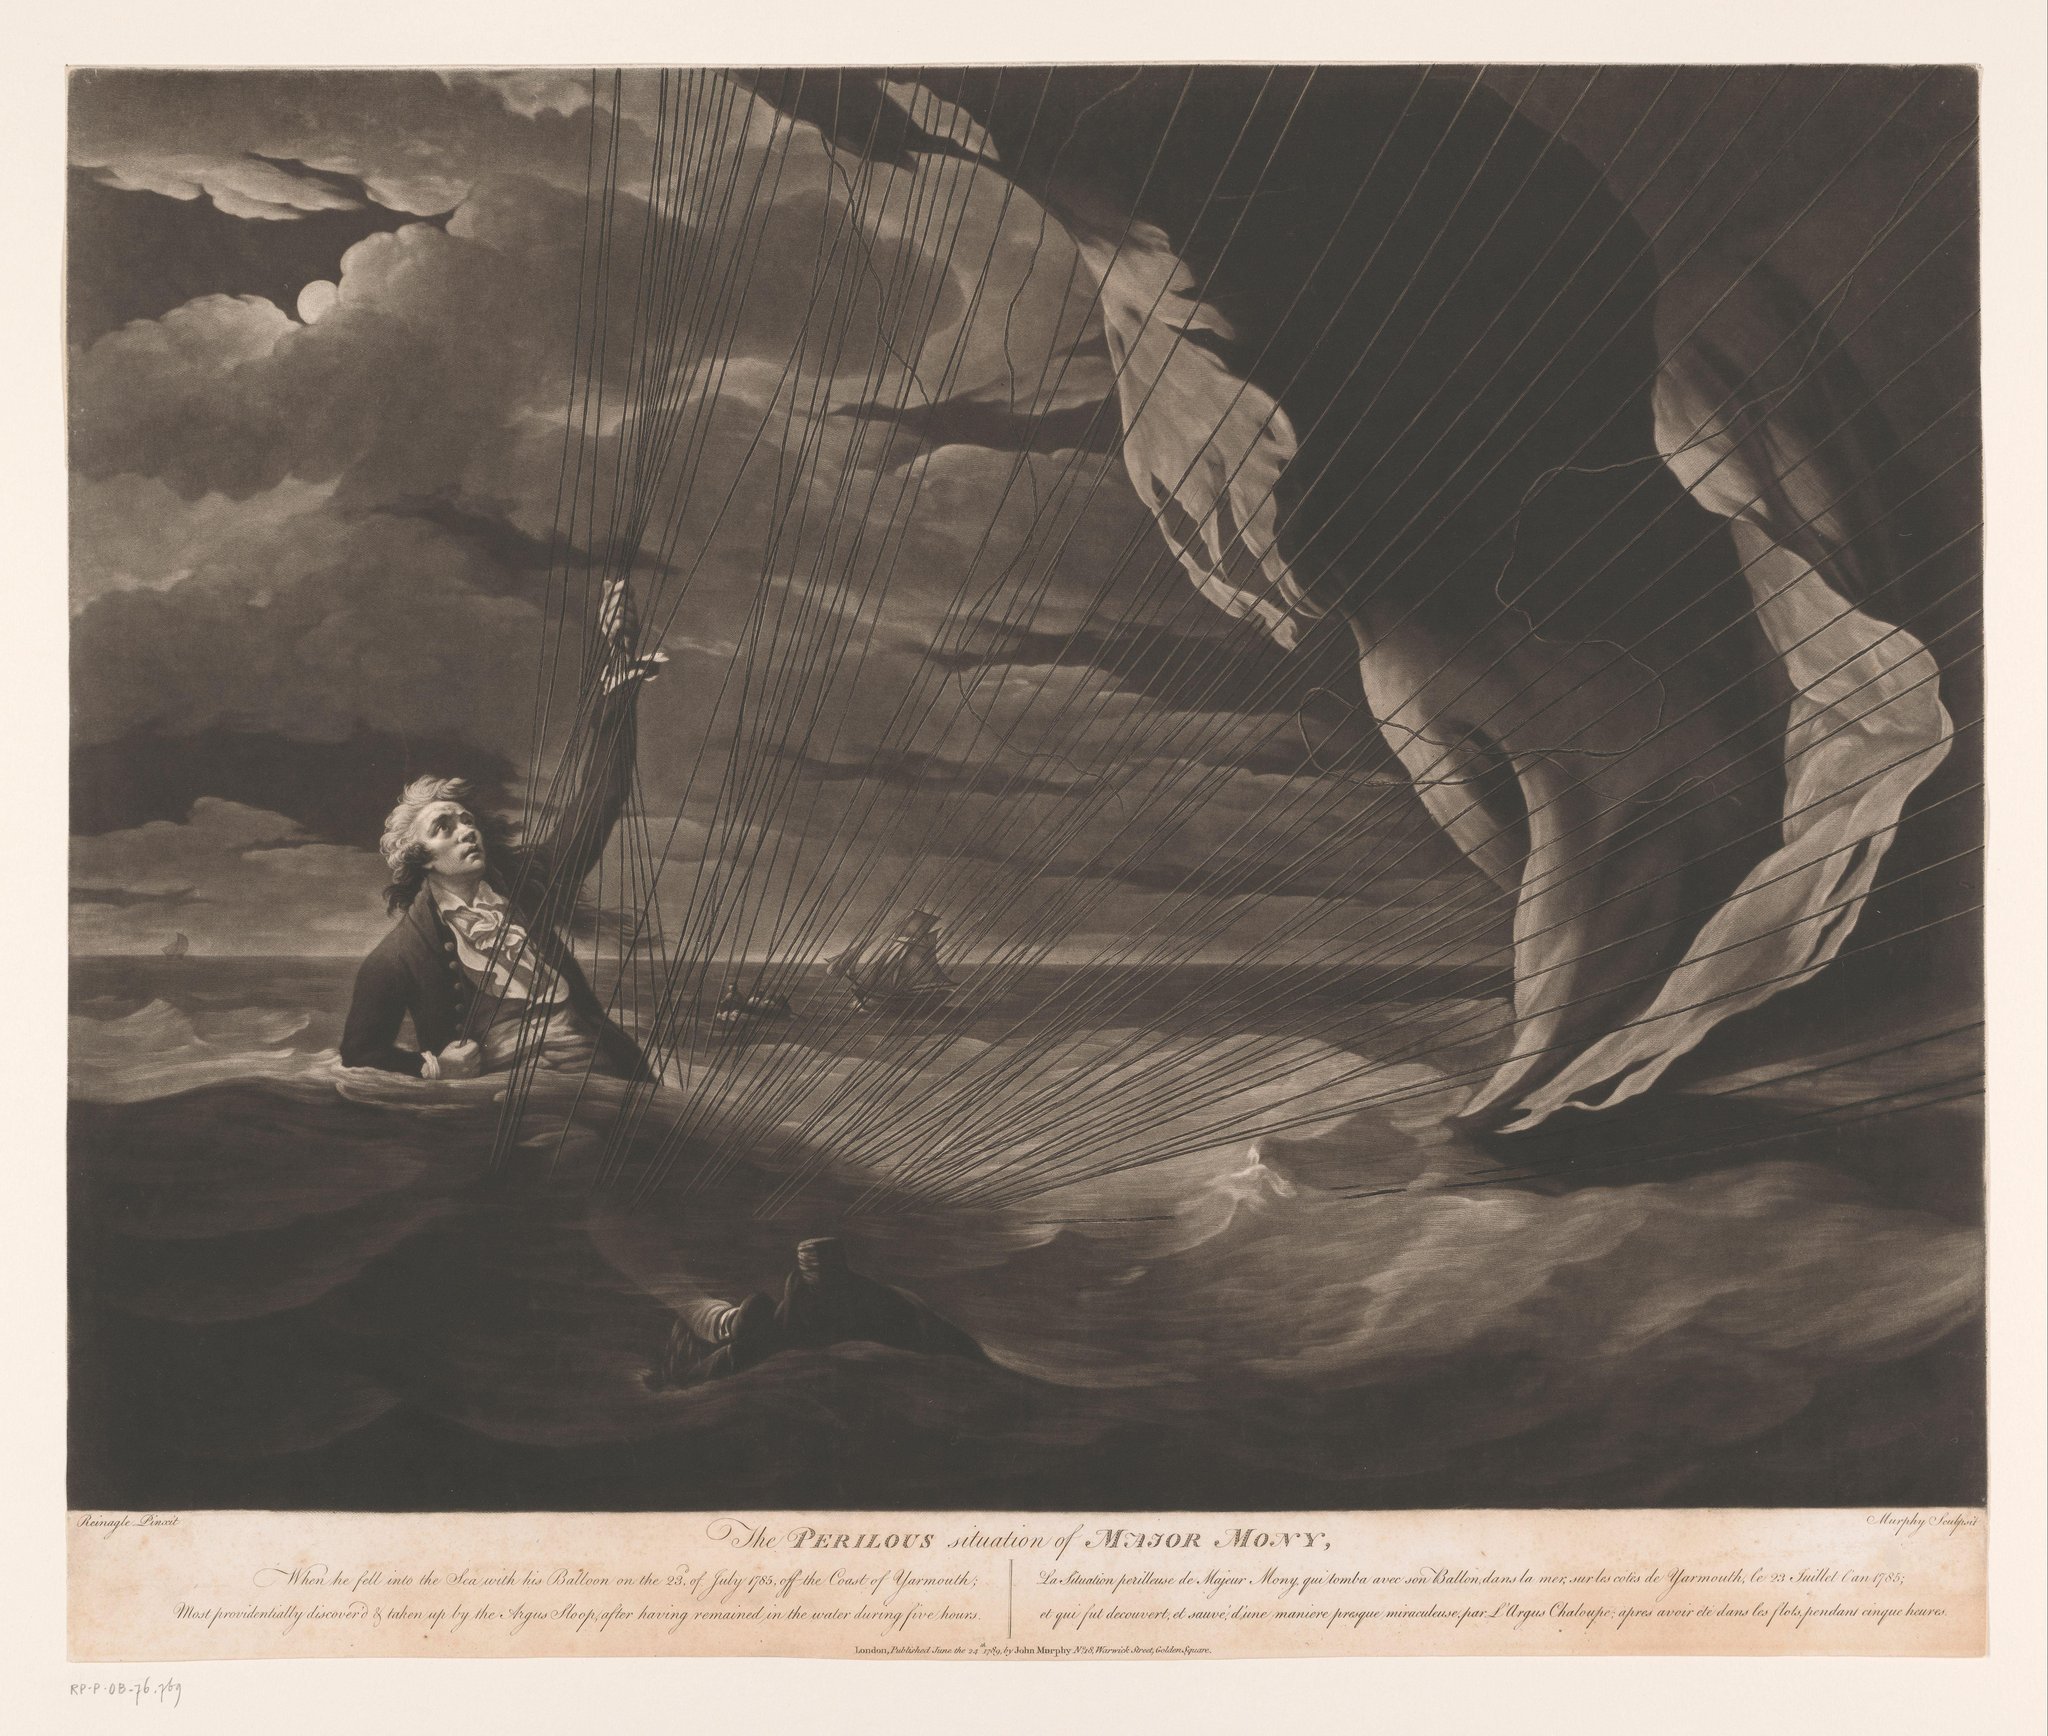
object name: print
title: The Perilous situation of Major Mony, 23 juli 1785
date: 1789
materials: paper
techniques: etching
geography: london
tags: balloon flight (sport), historical persons, air-crash, air disaster, flying-accident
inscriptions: collector's mark: Lugt 2760, collector's mark: Lugt 2228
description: Majoor John Money, aeronaut/luchtvaarder is met zijn luchtballon op 23 juli 1785 in zee gestort bij de kust van Yarmouth en wordt gered door de sloep 'Argus' nadat hij vijf uur in het water heeft gelegen, zich vasthoudend aan de touwen van de ballon. Tekst in het Engels en het Frans in de ondermarge.